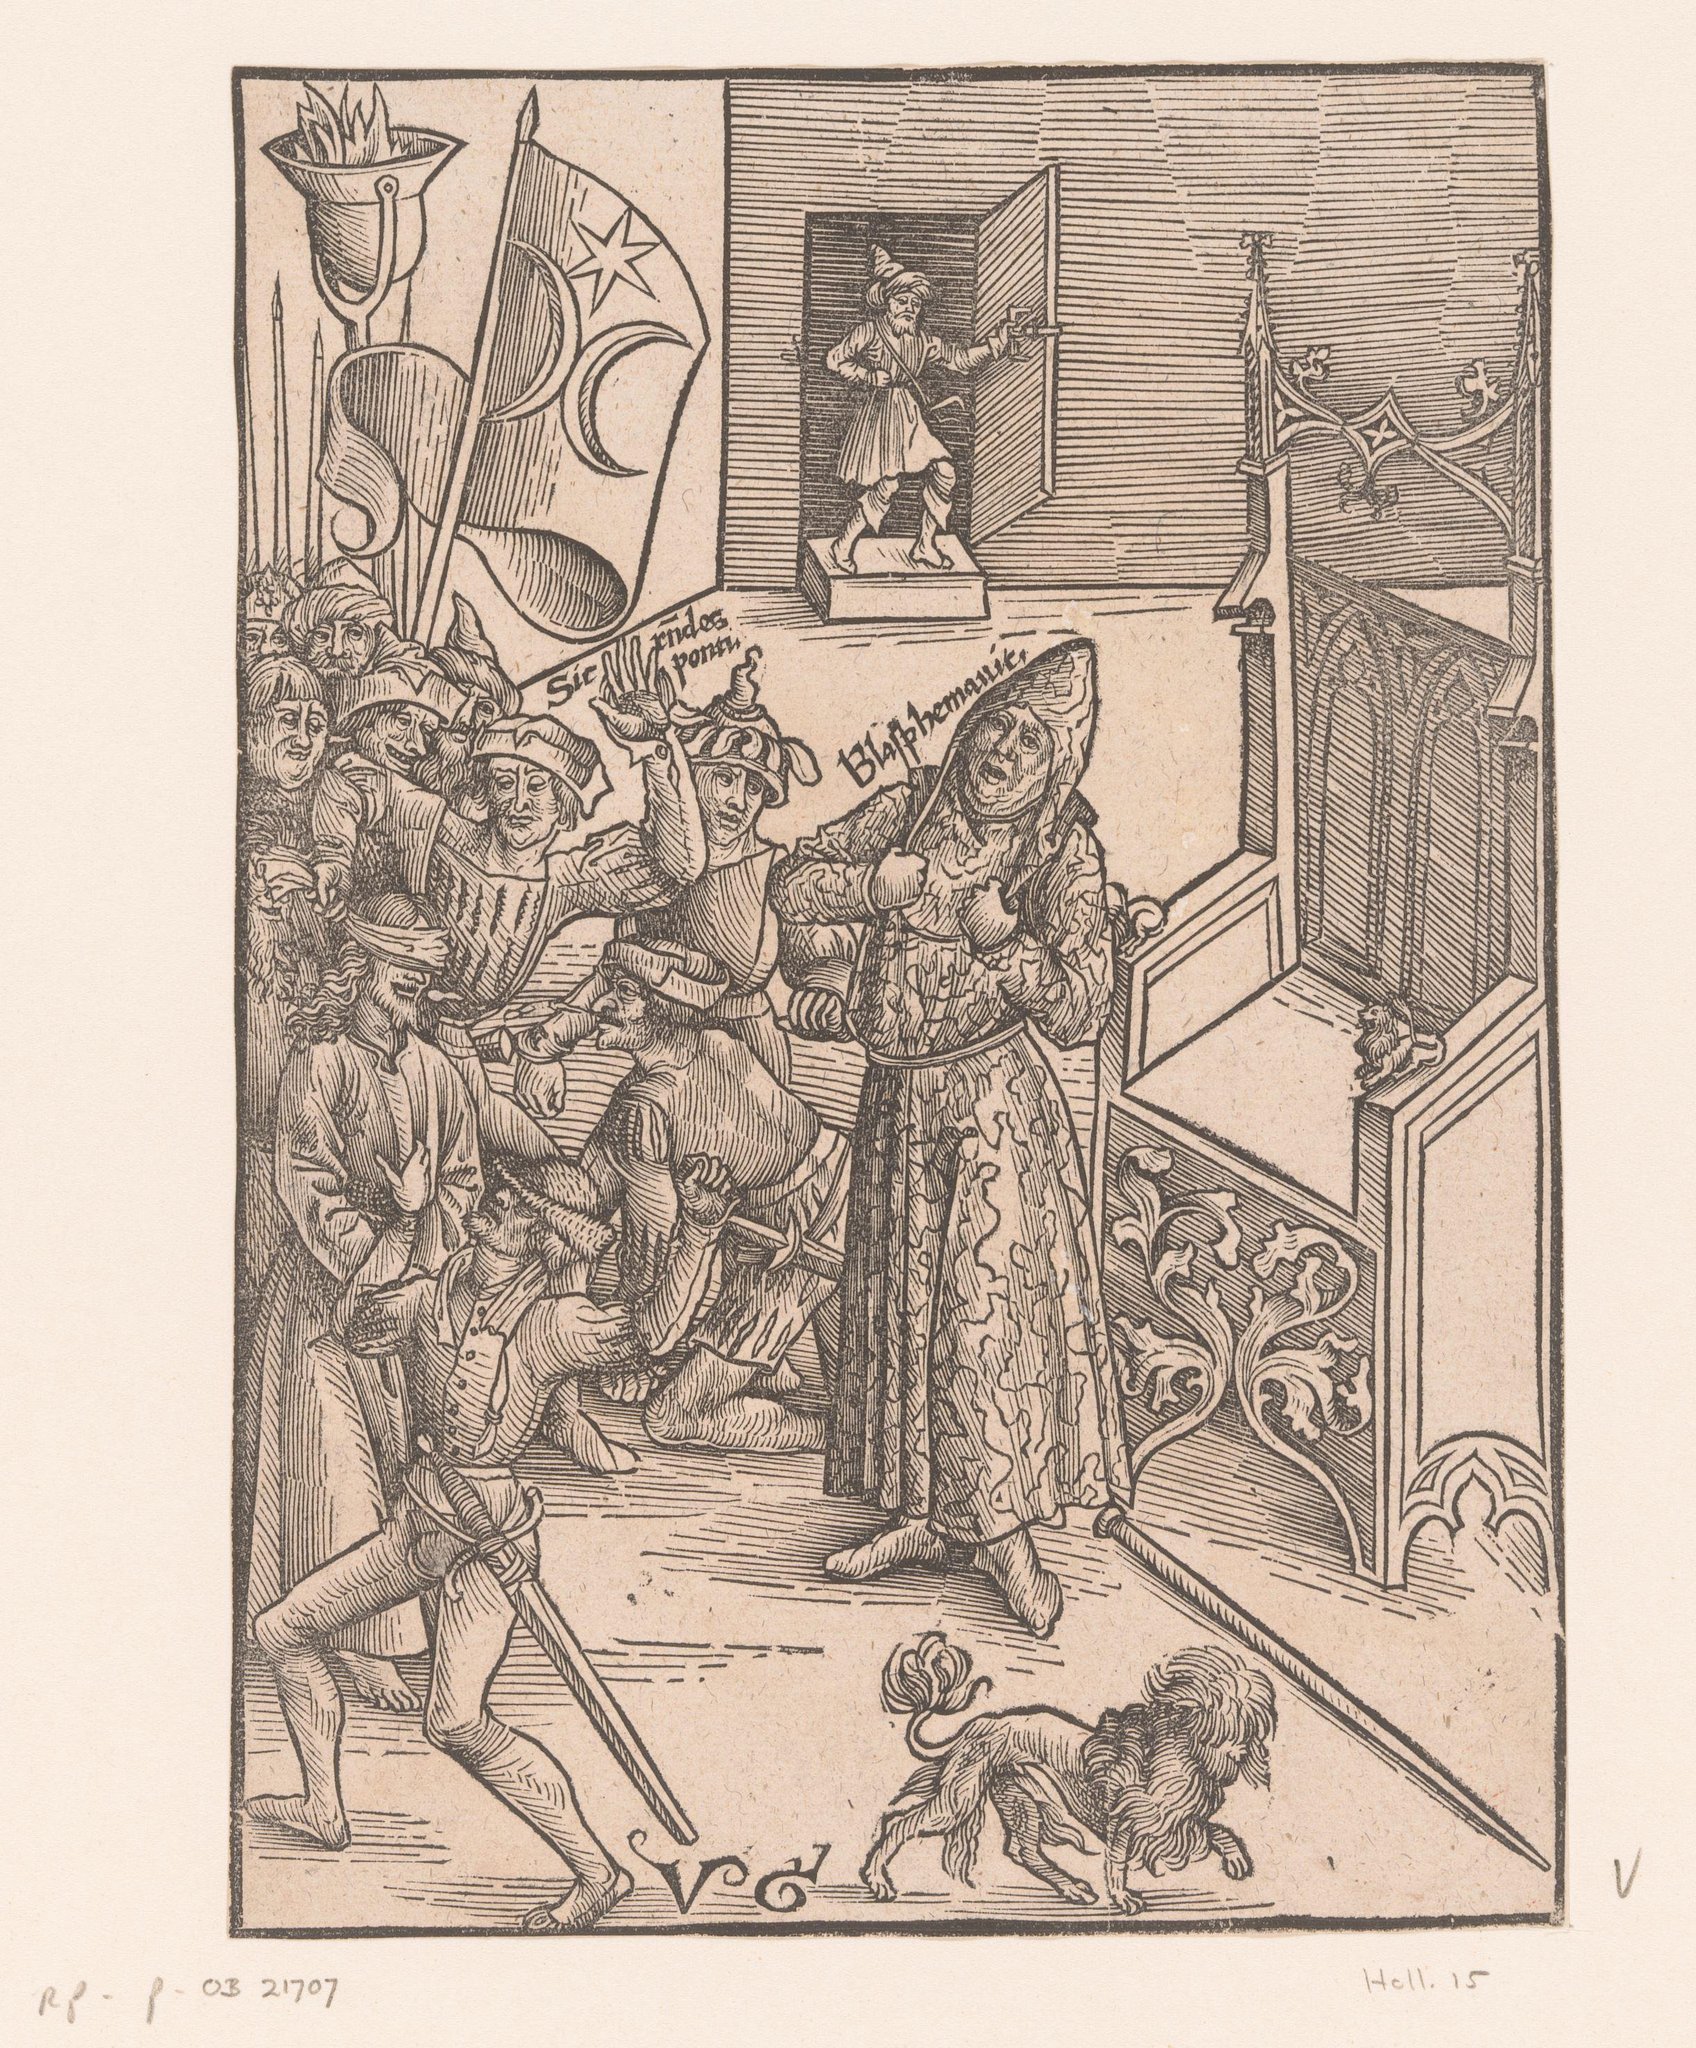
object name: print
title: Christus voor Kajafas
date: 1506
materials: paper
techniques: woodcut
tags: in caiaphas' palace christ is mocked by jews (matthew 26:67-68; mark 14:65)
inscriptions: collector's mark: Lugt 240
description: Afkomstig uit: Der Text des Passions oder Lidens Christi (...). Straatsburg: N. Ringmann, 1506.